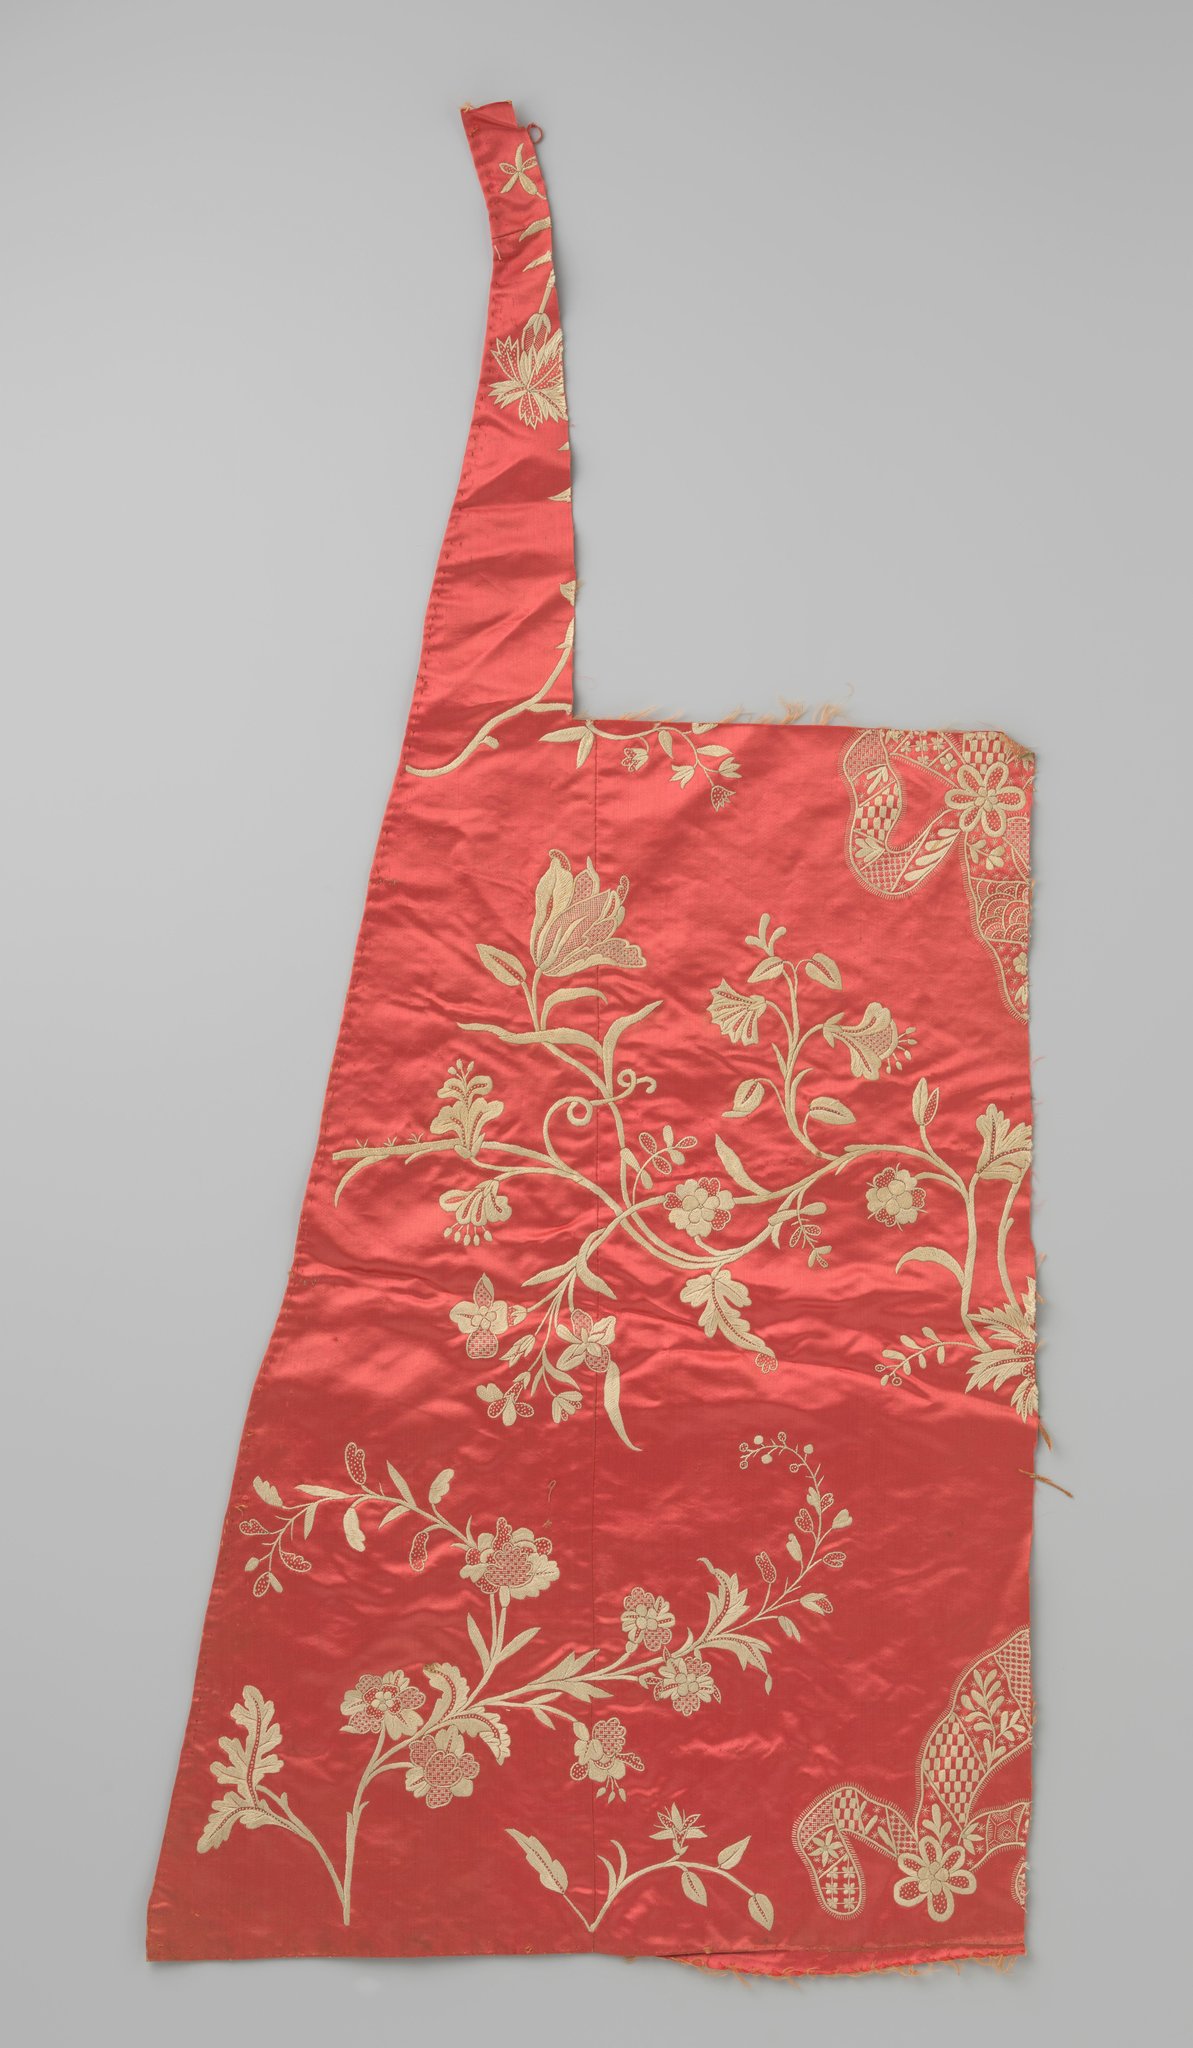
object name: fragment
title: Embroidered Interior Textile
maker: Anonymous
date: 1750-1760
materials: silk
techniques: embroidered, weave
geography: france